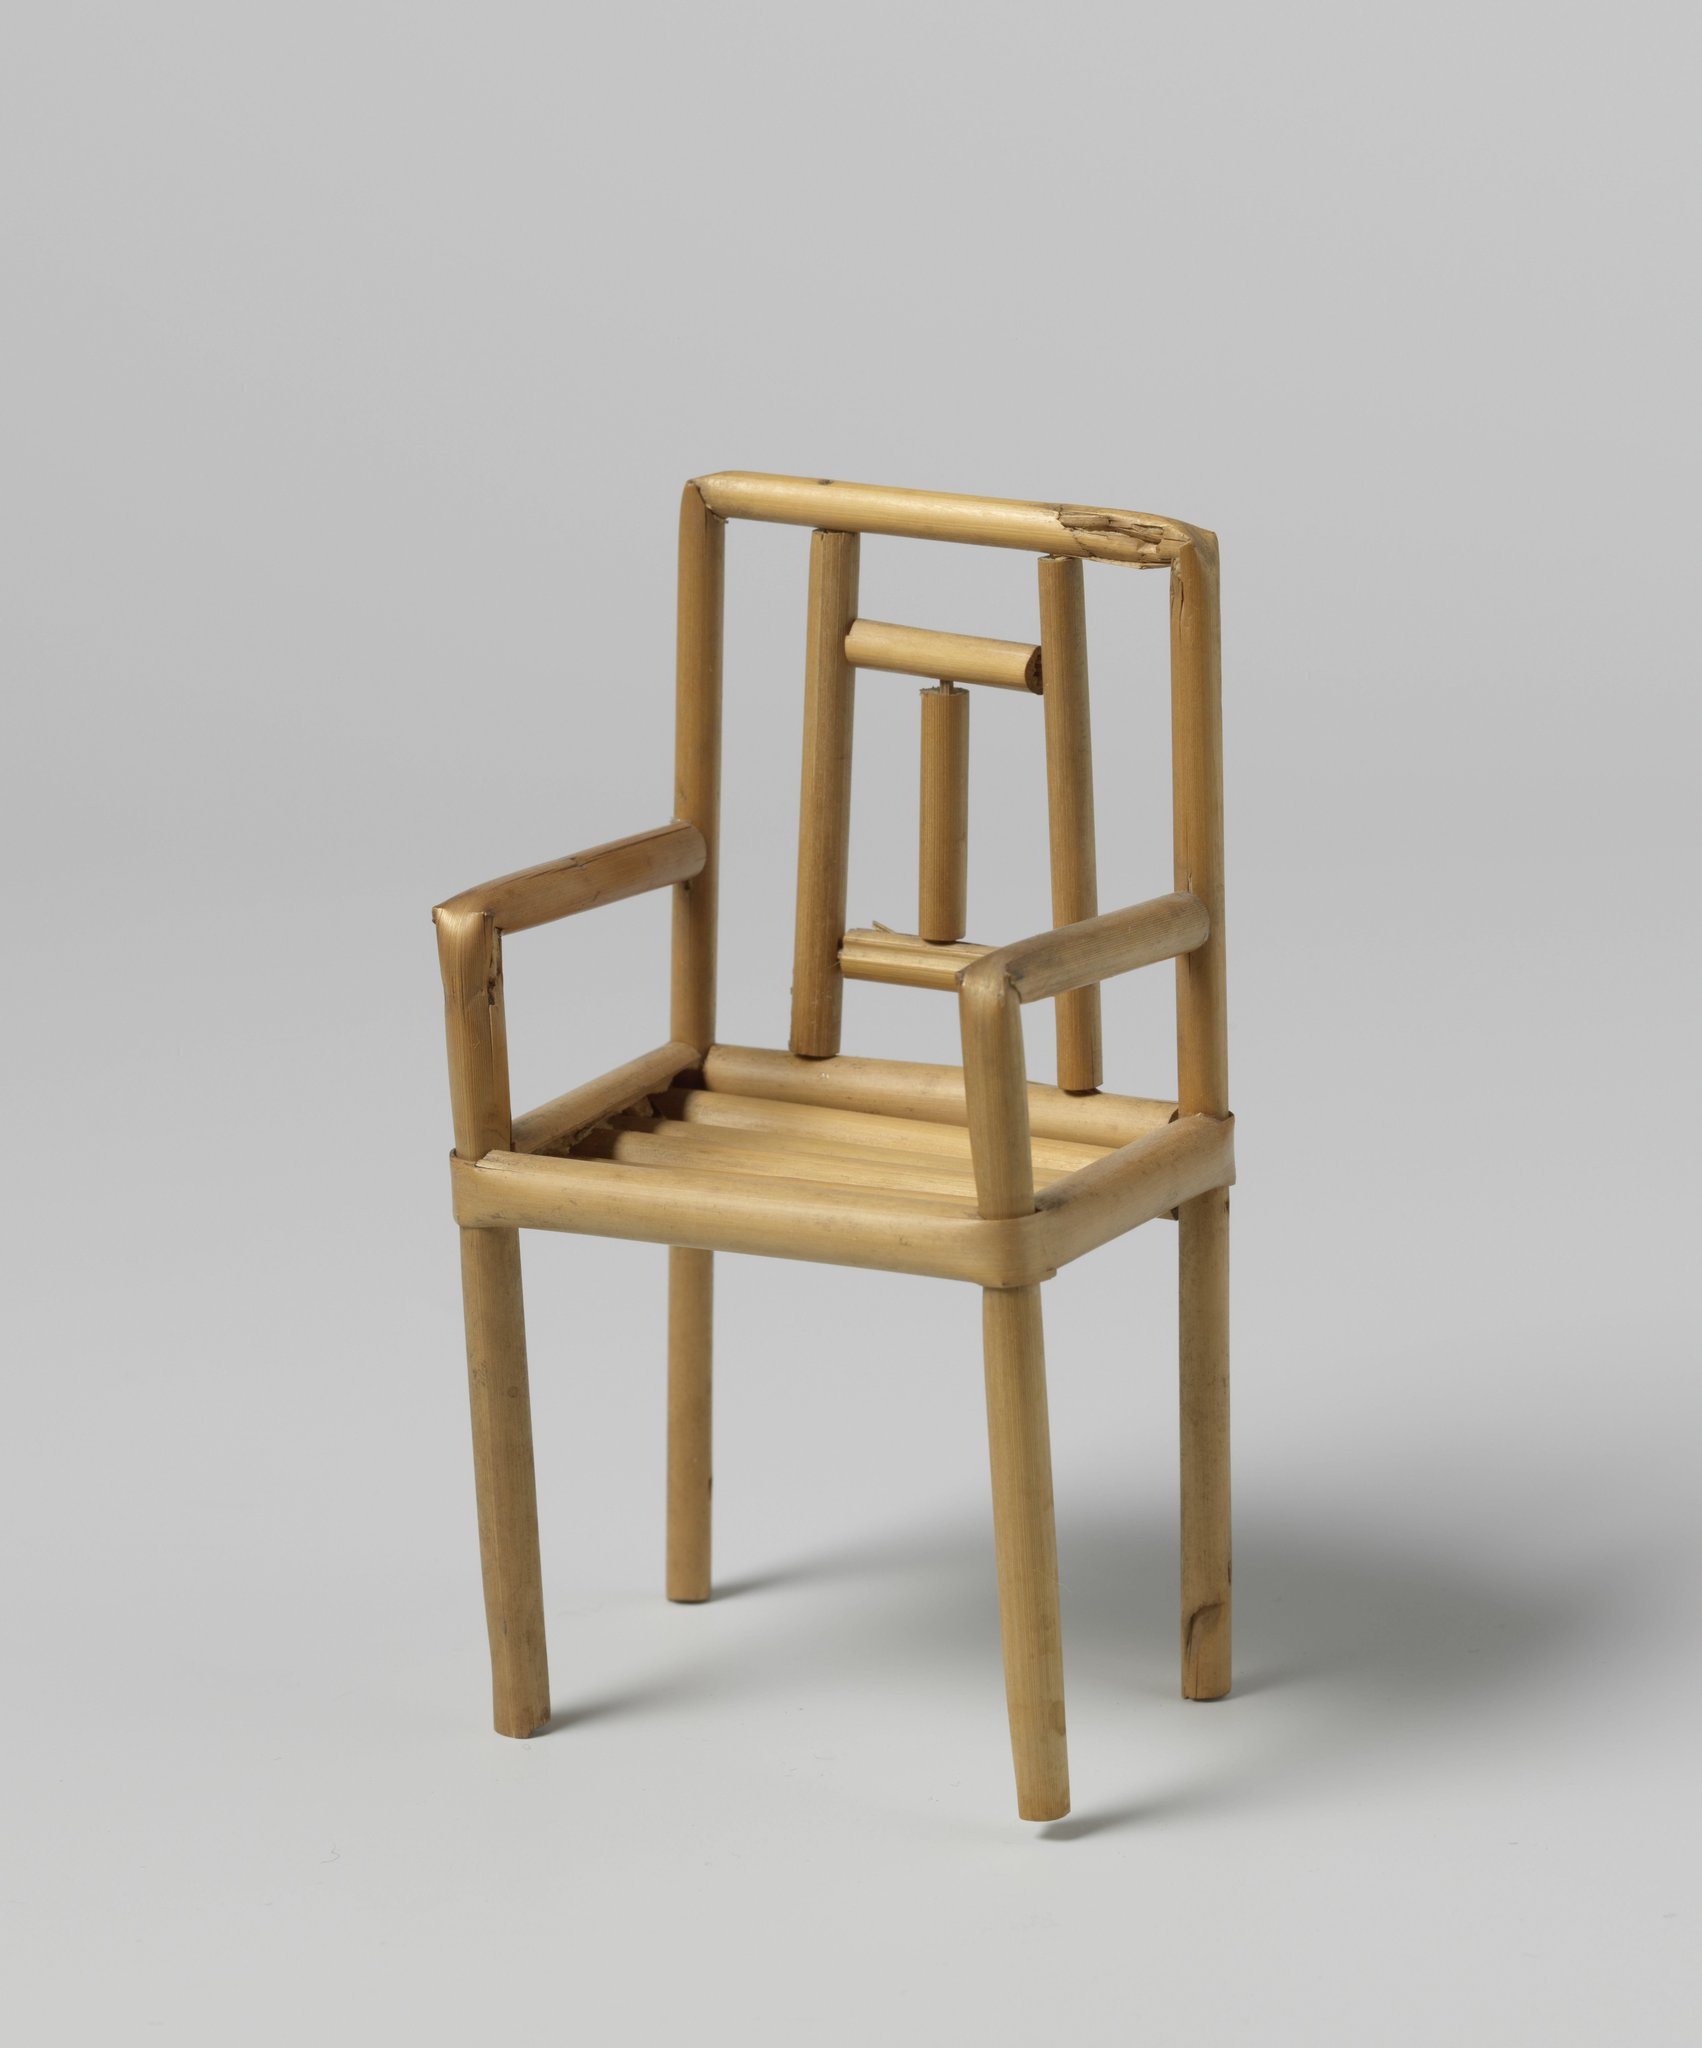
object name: miniature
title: Stoel van vlechtwerk, met geometrische motieven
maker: Anonymous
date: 1800-1899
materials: wood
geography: england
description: Stoel vervaardigd van gebogen, en op houten pennetjes geregen staafjes Kleine lisdodde. De rugleuning met geometrische motieven. De poten onderling verbonden met dwarsregels. De zitting is vervaardigd van 5 in de breedte bevestigde gehalveerde stengels.